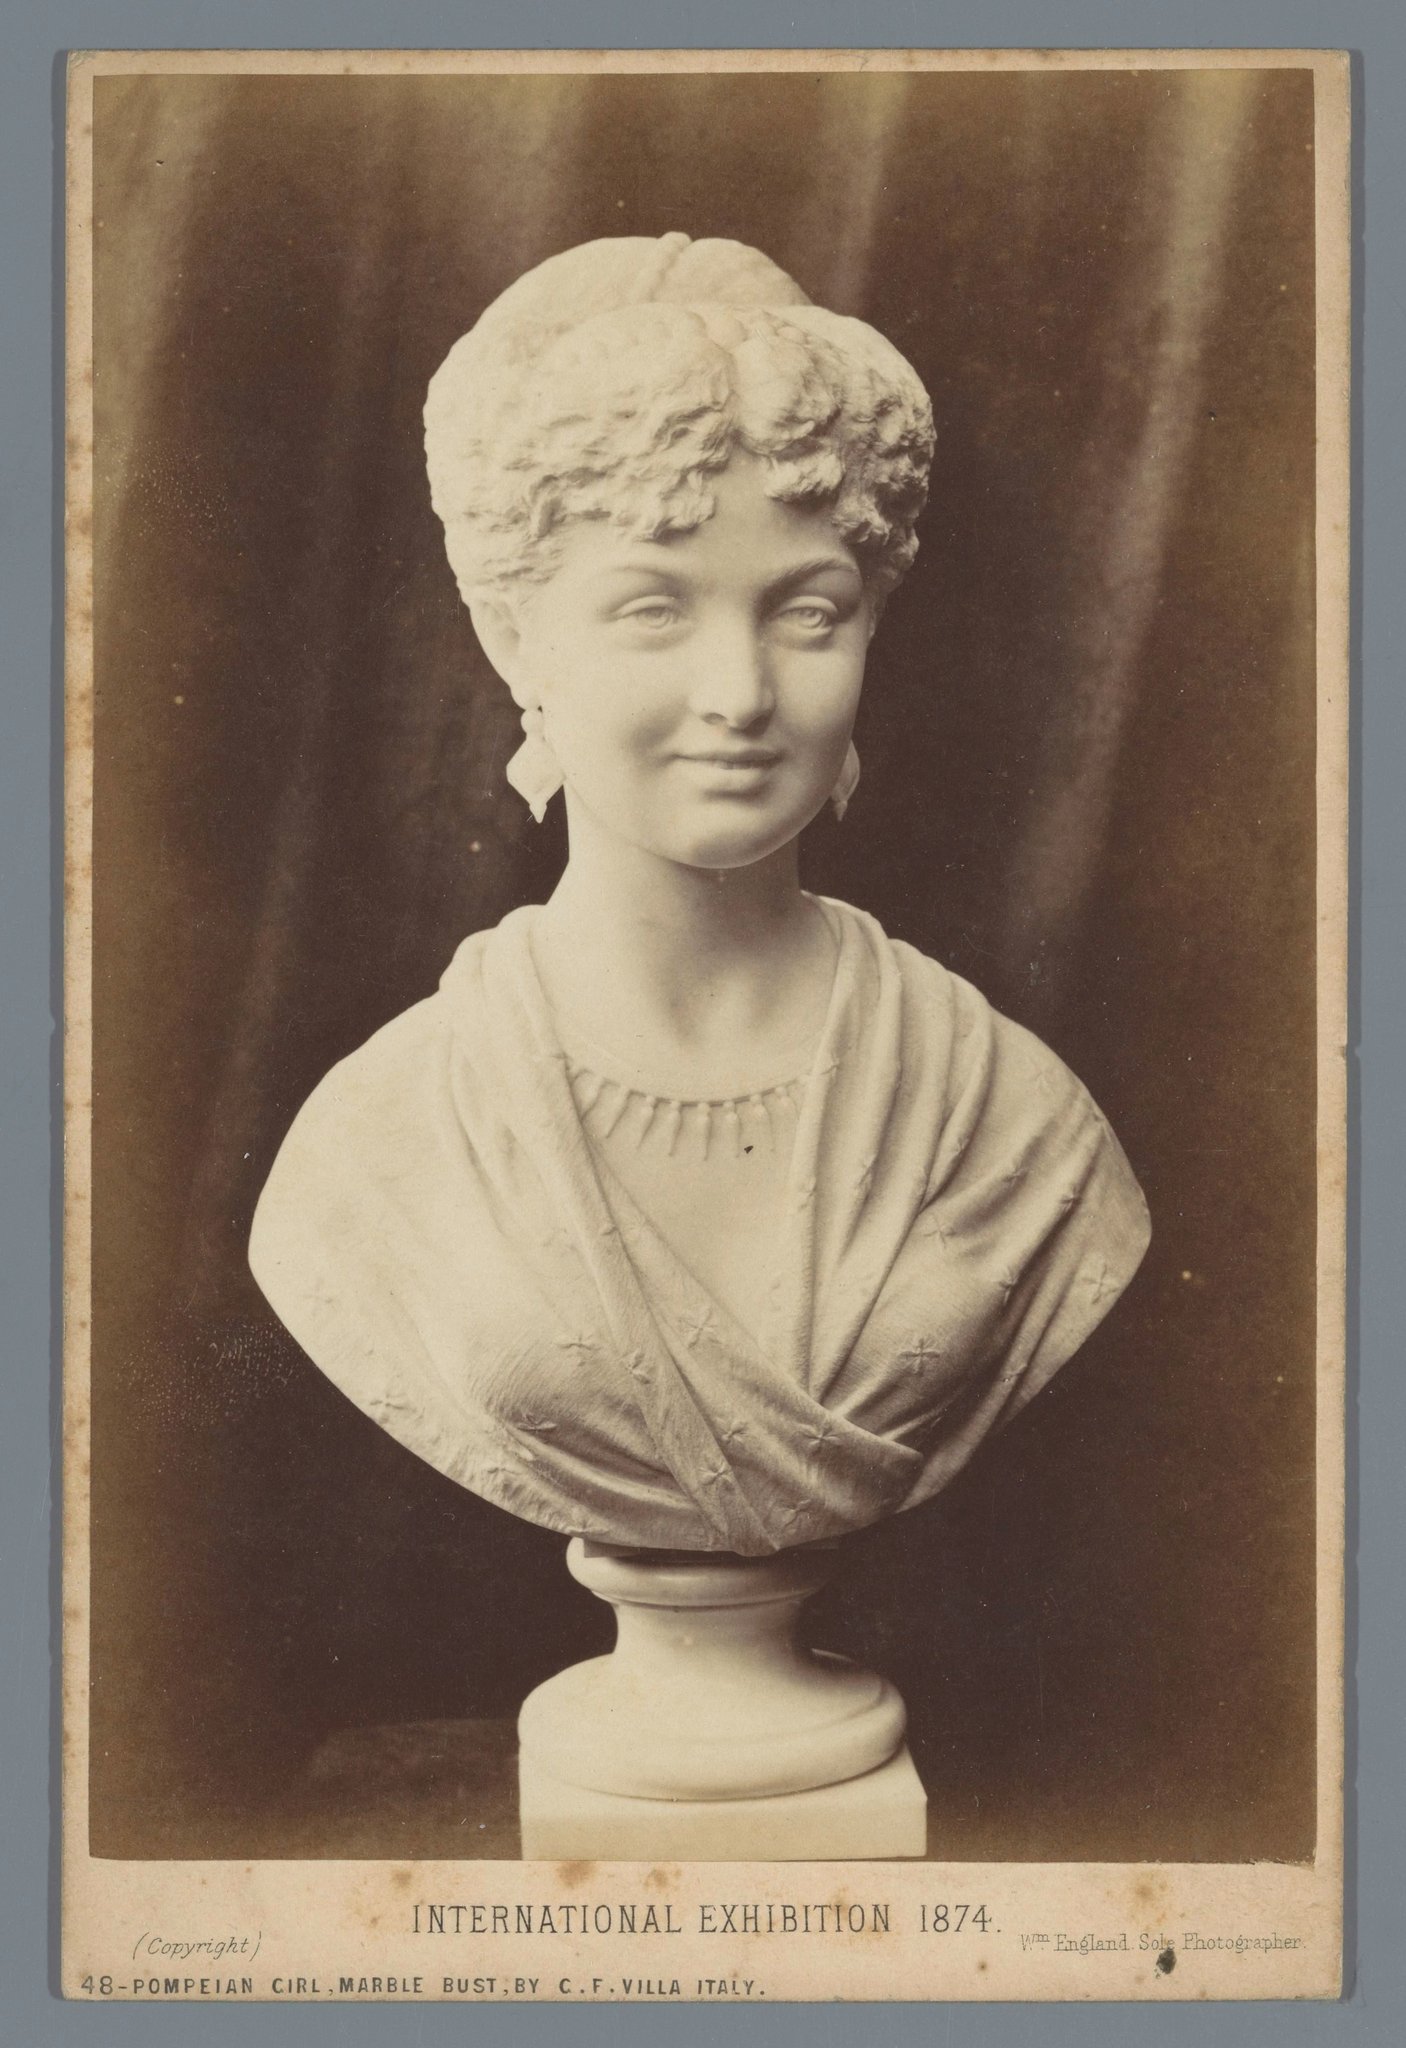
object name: cabinet photograph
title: Marmeren buste Pompeïsch Meisje door C.F. Villa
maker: william england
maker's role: fotograaf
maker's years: 1816-1896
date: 1874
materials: cardboard, photographic support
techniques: albumen print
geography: london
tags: monument, statue, london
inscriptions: number: ‘60’, number: ‘48’